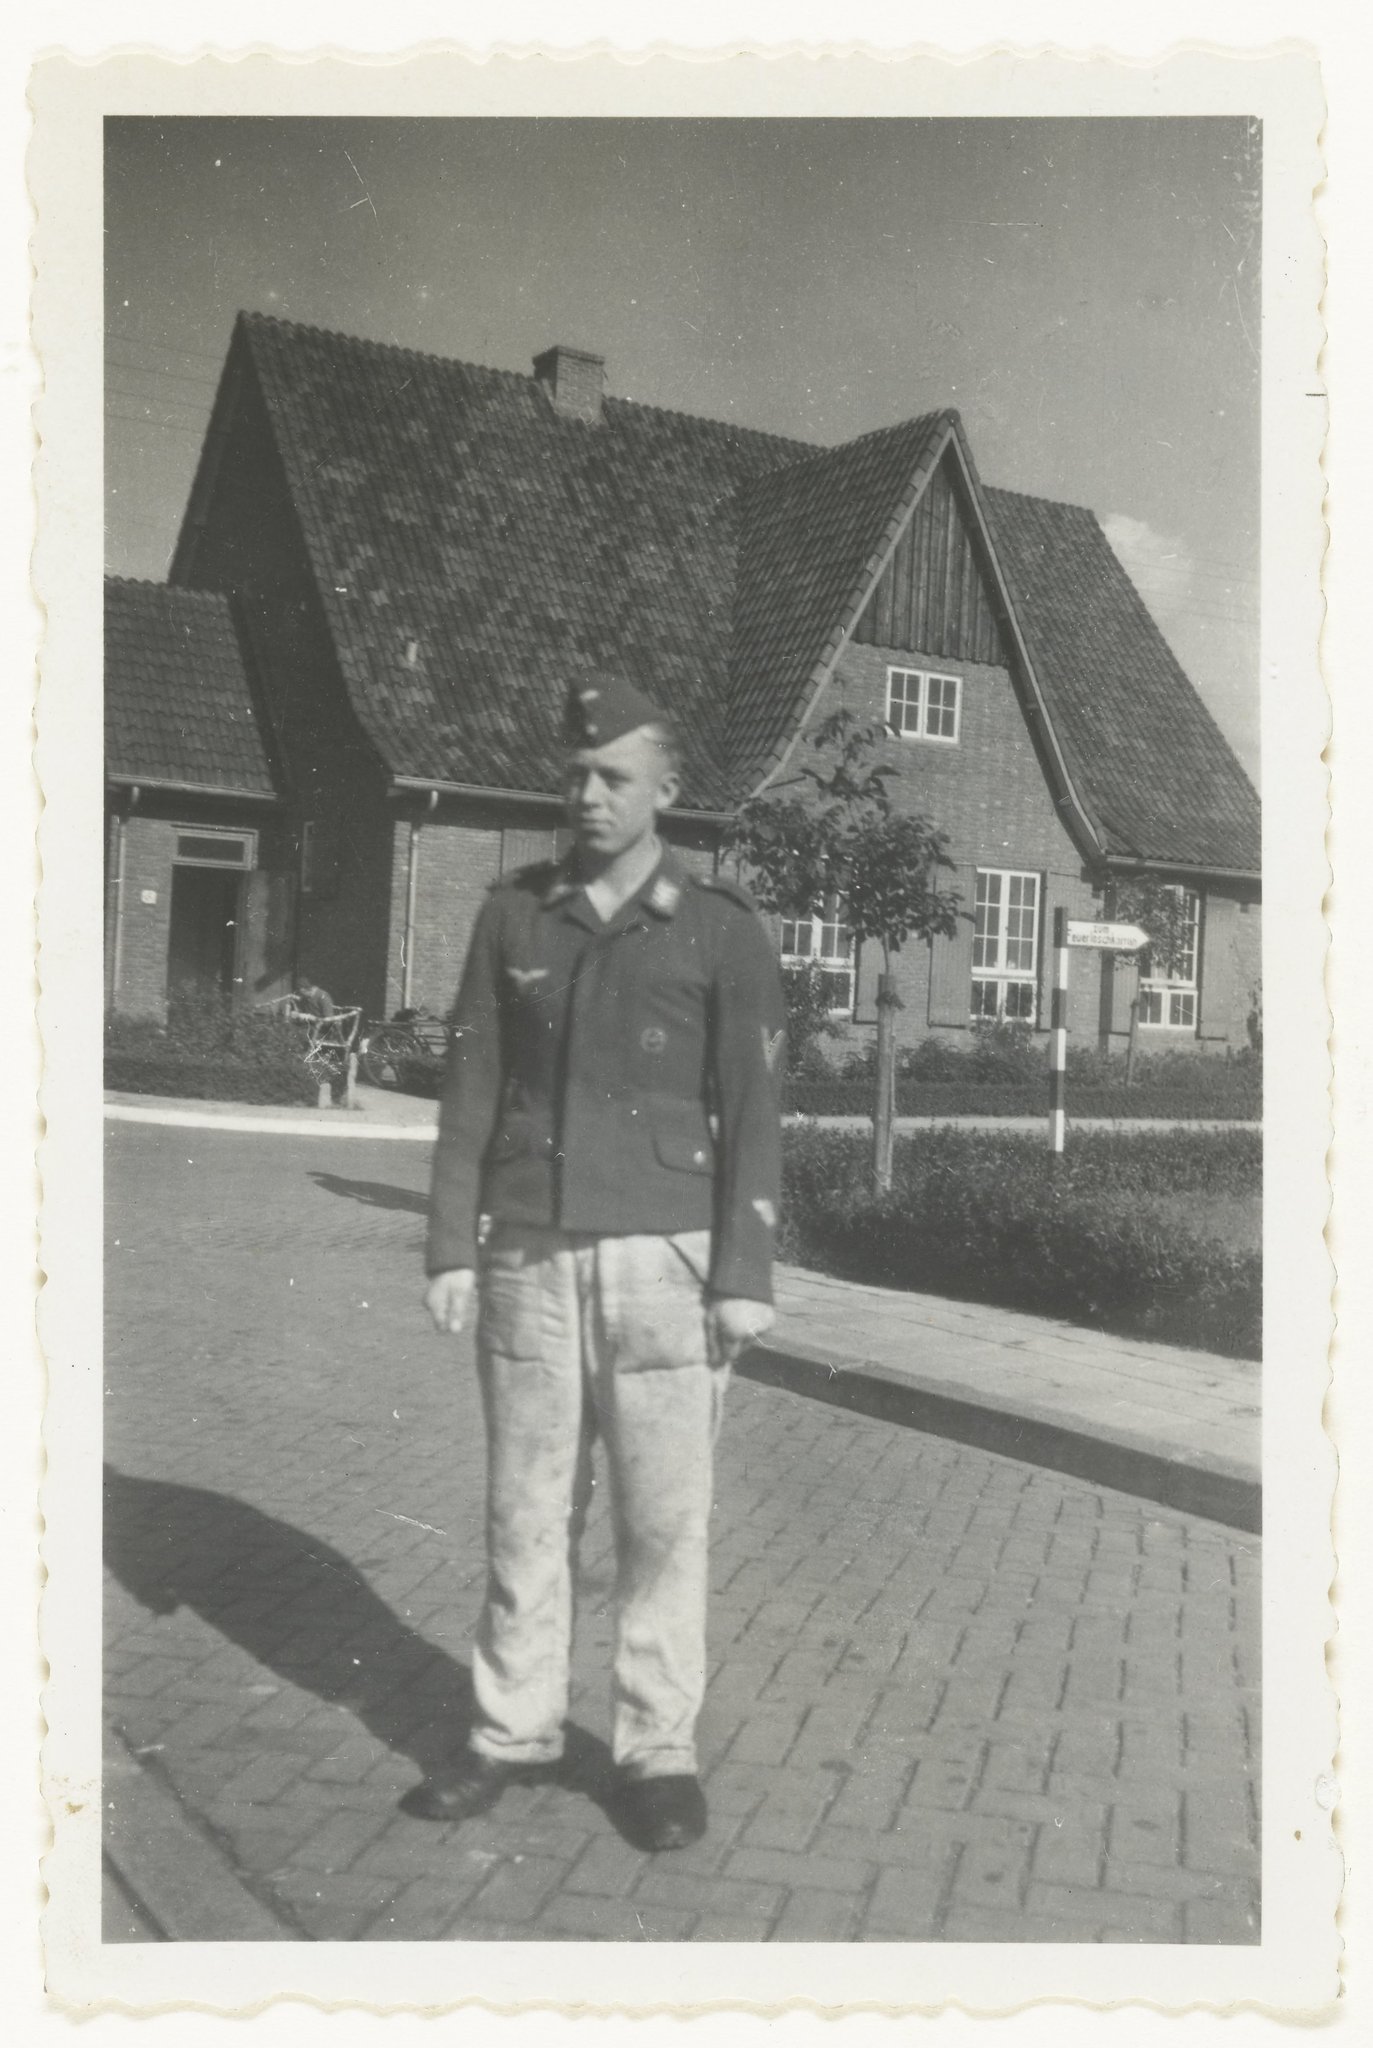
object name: photograph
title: Luftwaffe militair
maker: Anonymous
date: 1941-1942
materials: photographic support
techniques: gelatin silver print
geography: netherlands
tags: the soldier; the soldier's life, occupation ~ war, netherlands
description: Een Luftwaffe militair in een straat met achter hem een huis.